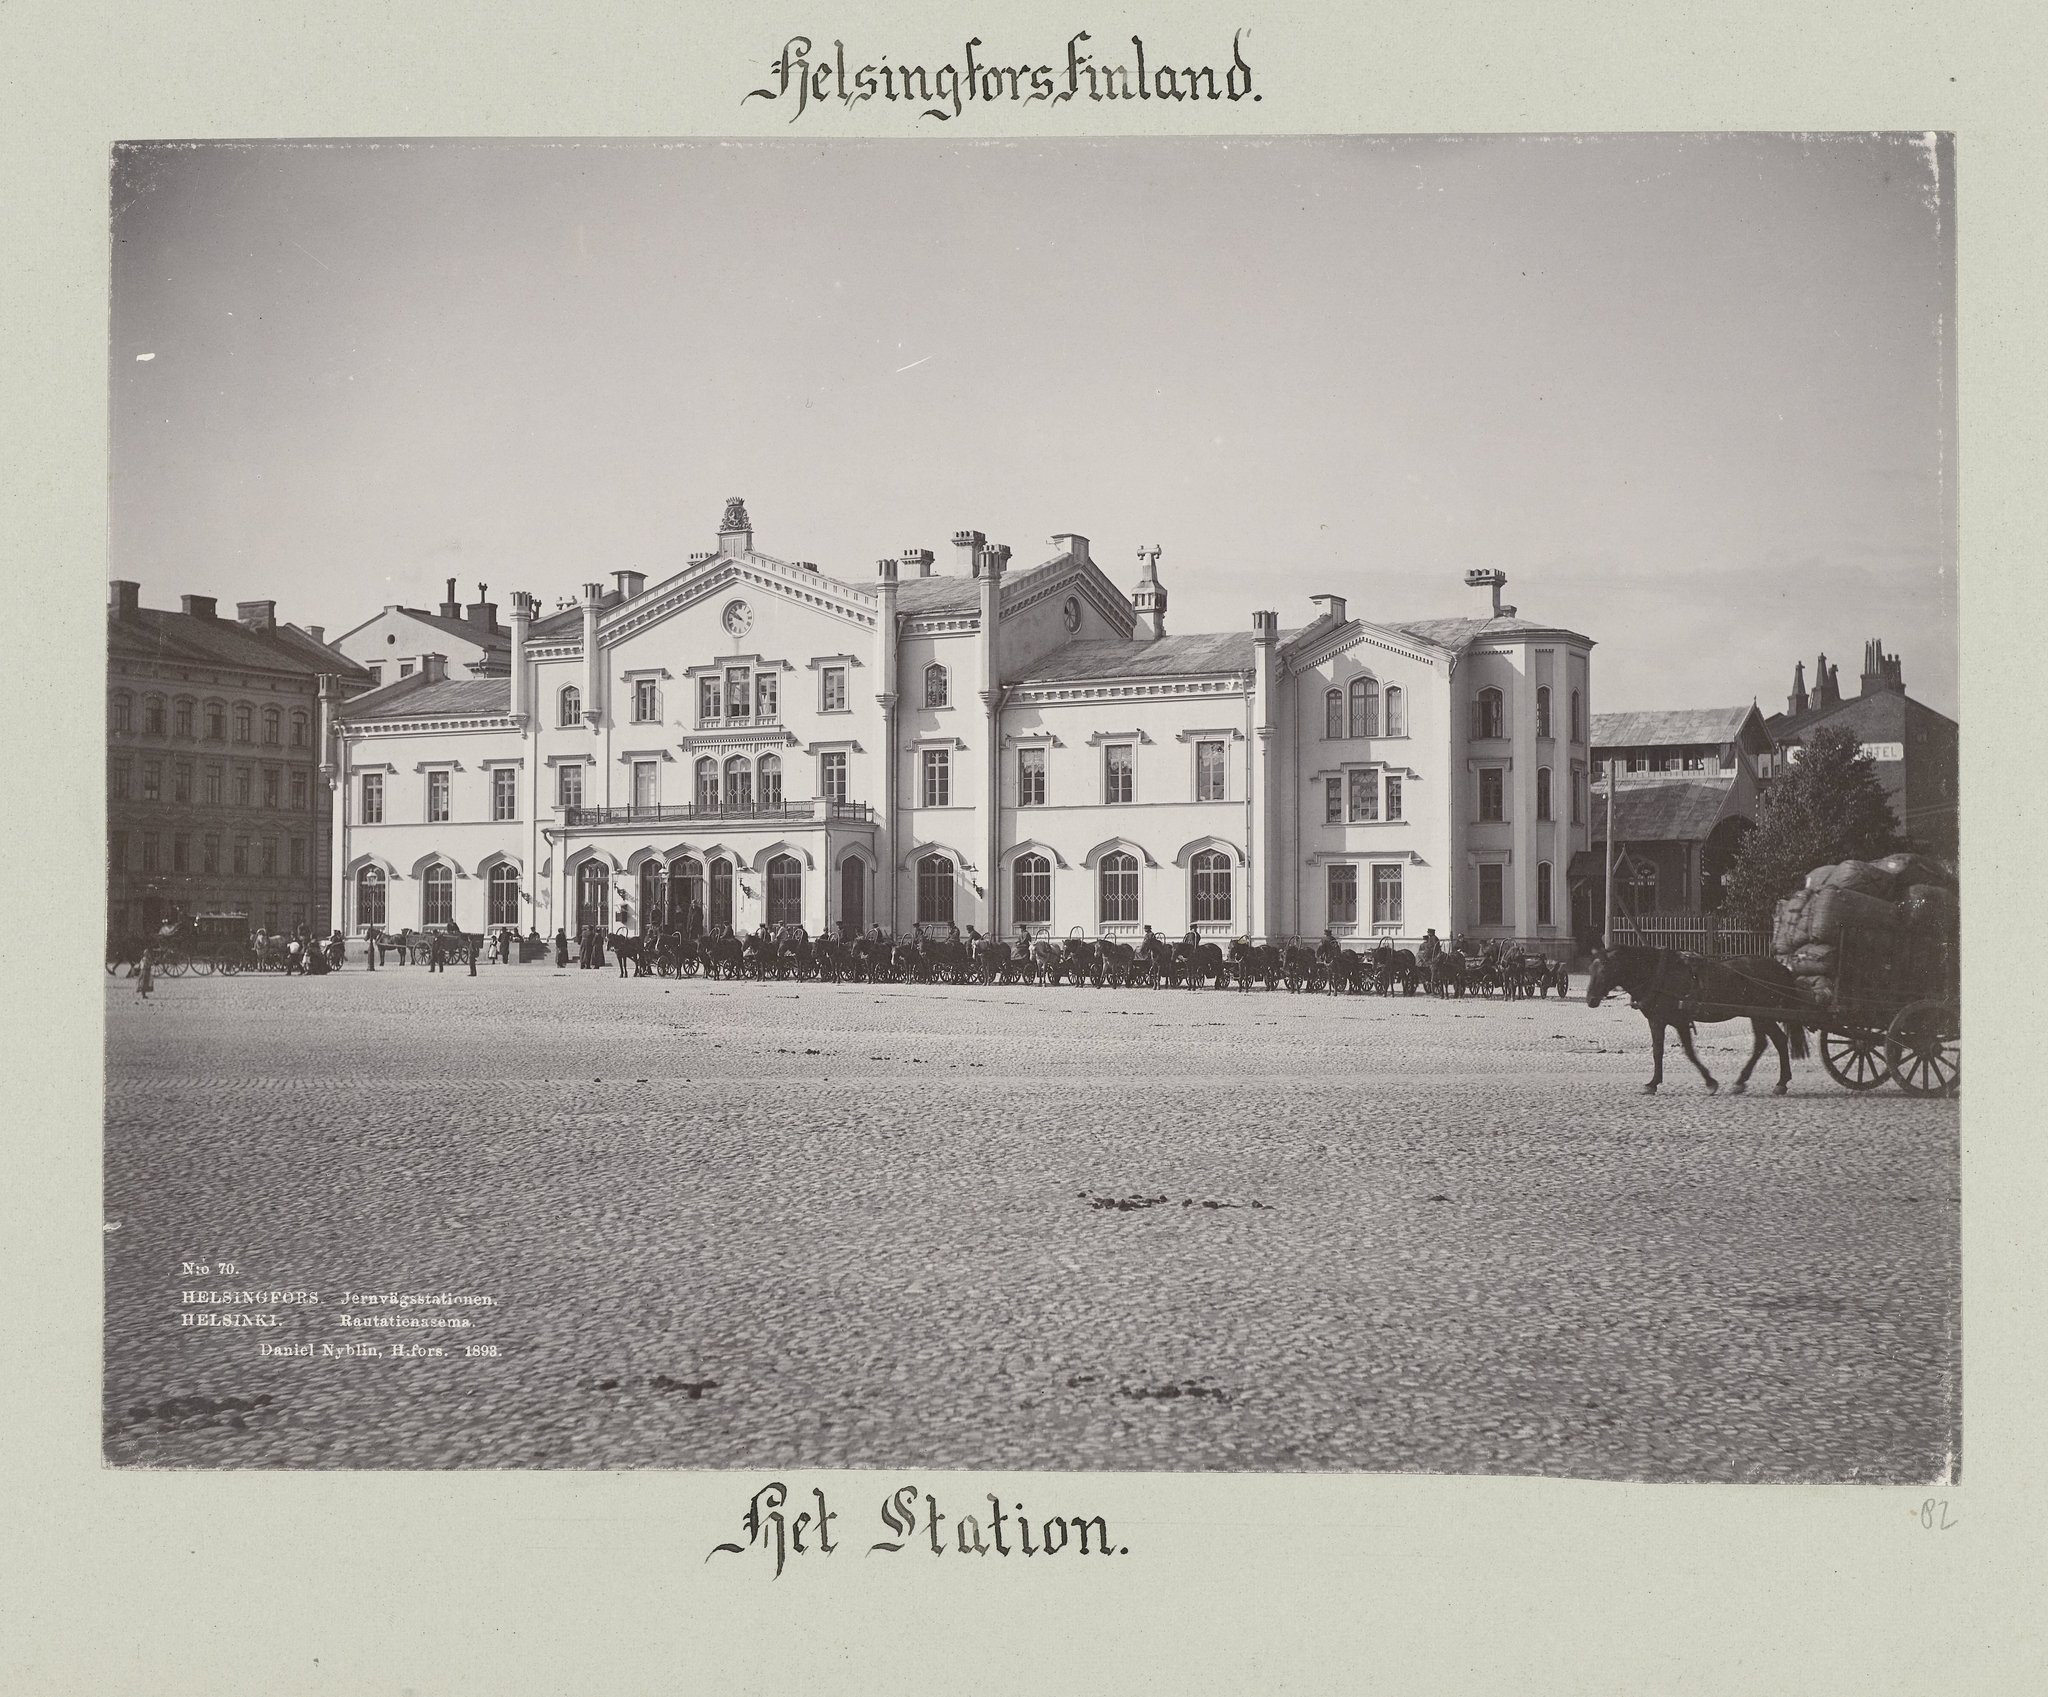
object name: photograph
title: Oude treinstation van Helsinki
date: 1893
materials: paper, photographic support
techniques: albumen print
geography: netherlands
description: Het oude treinstation in Helsinki, ontworpen door Carl Albert Edelfelt en gebouwd in 1890. Op het staionsplein voor het station staan een aantal paarden met rijtuigen te wachten op passagiers.